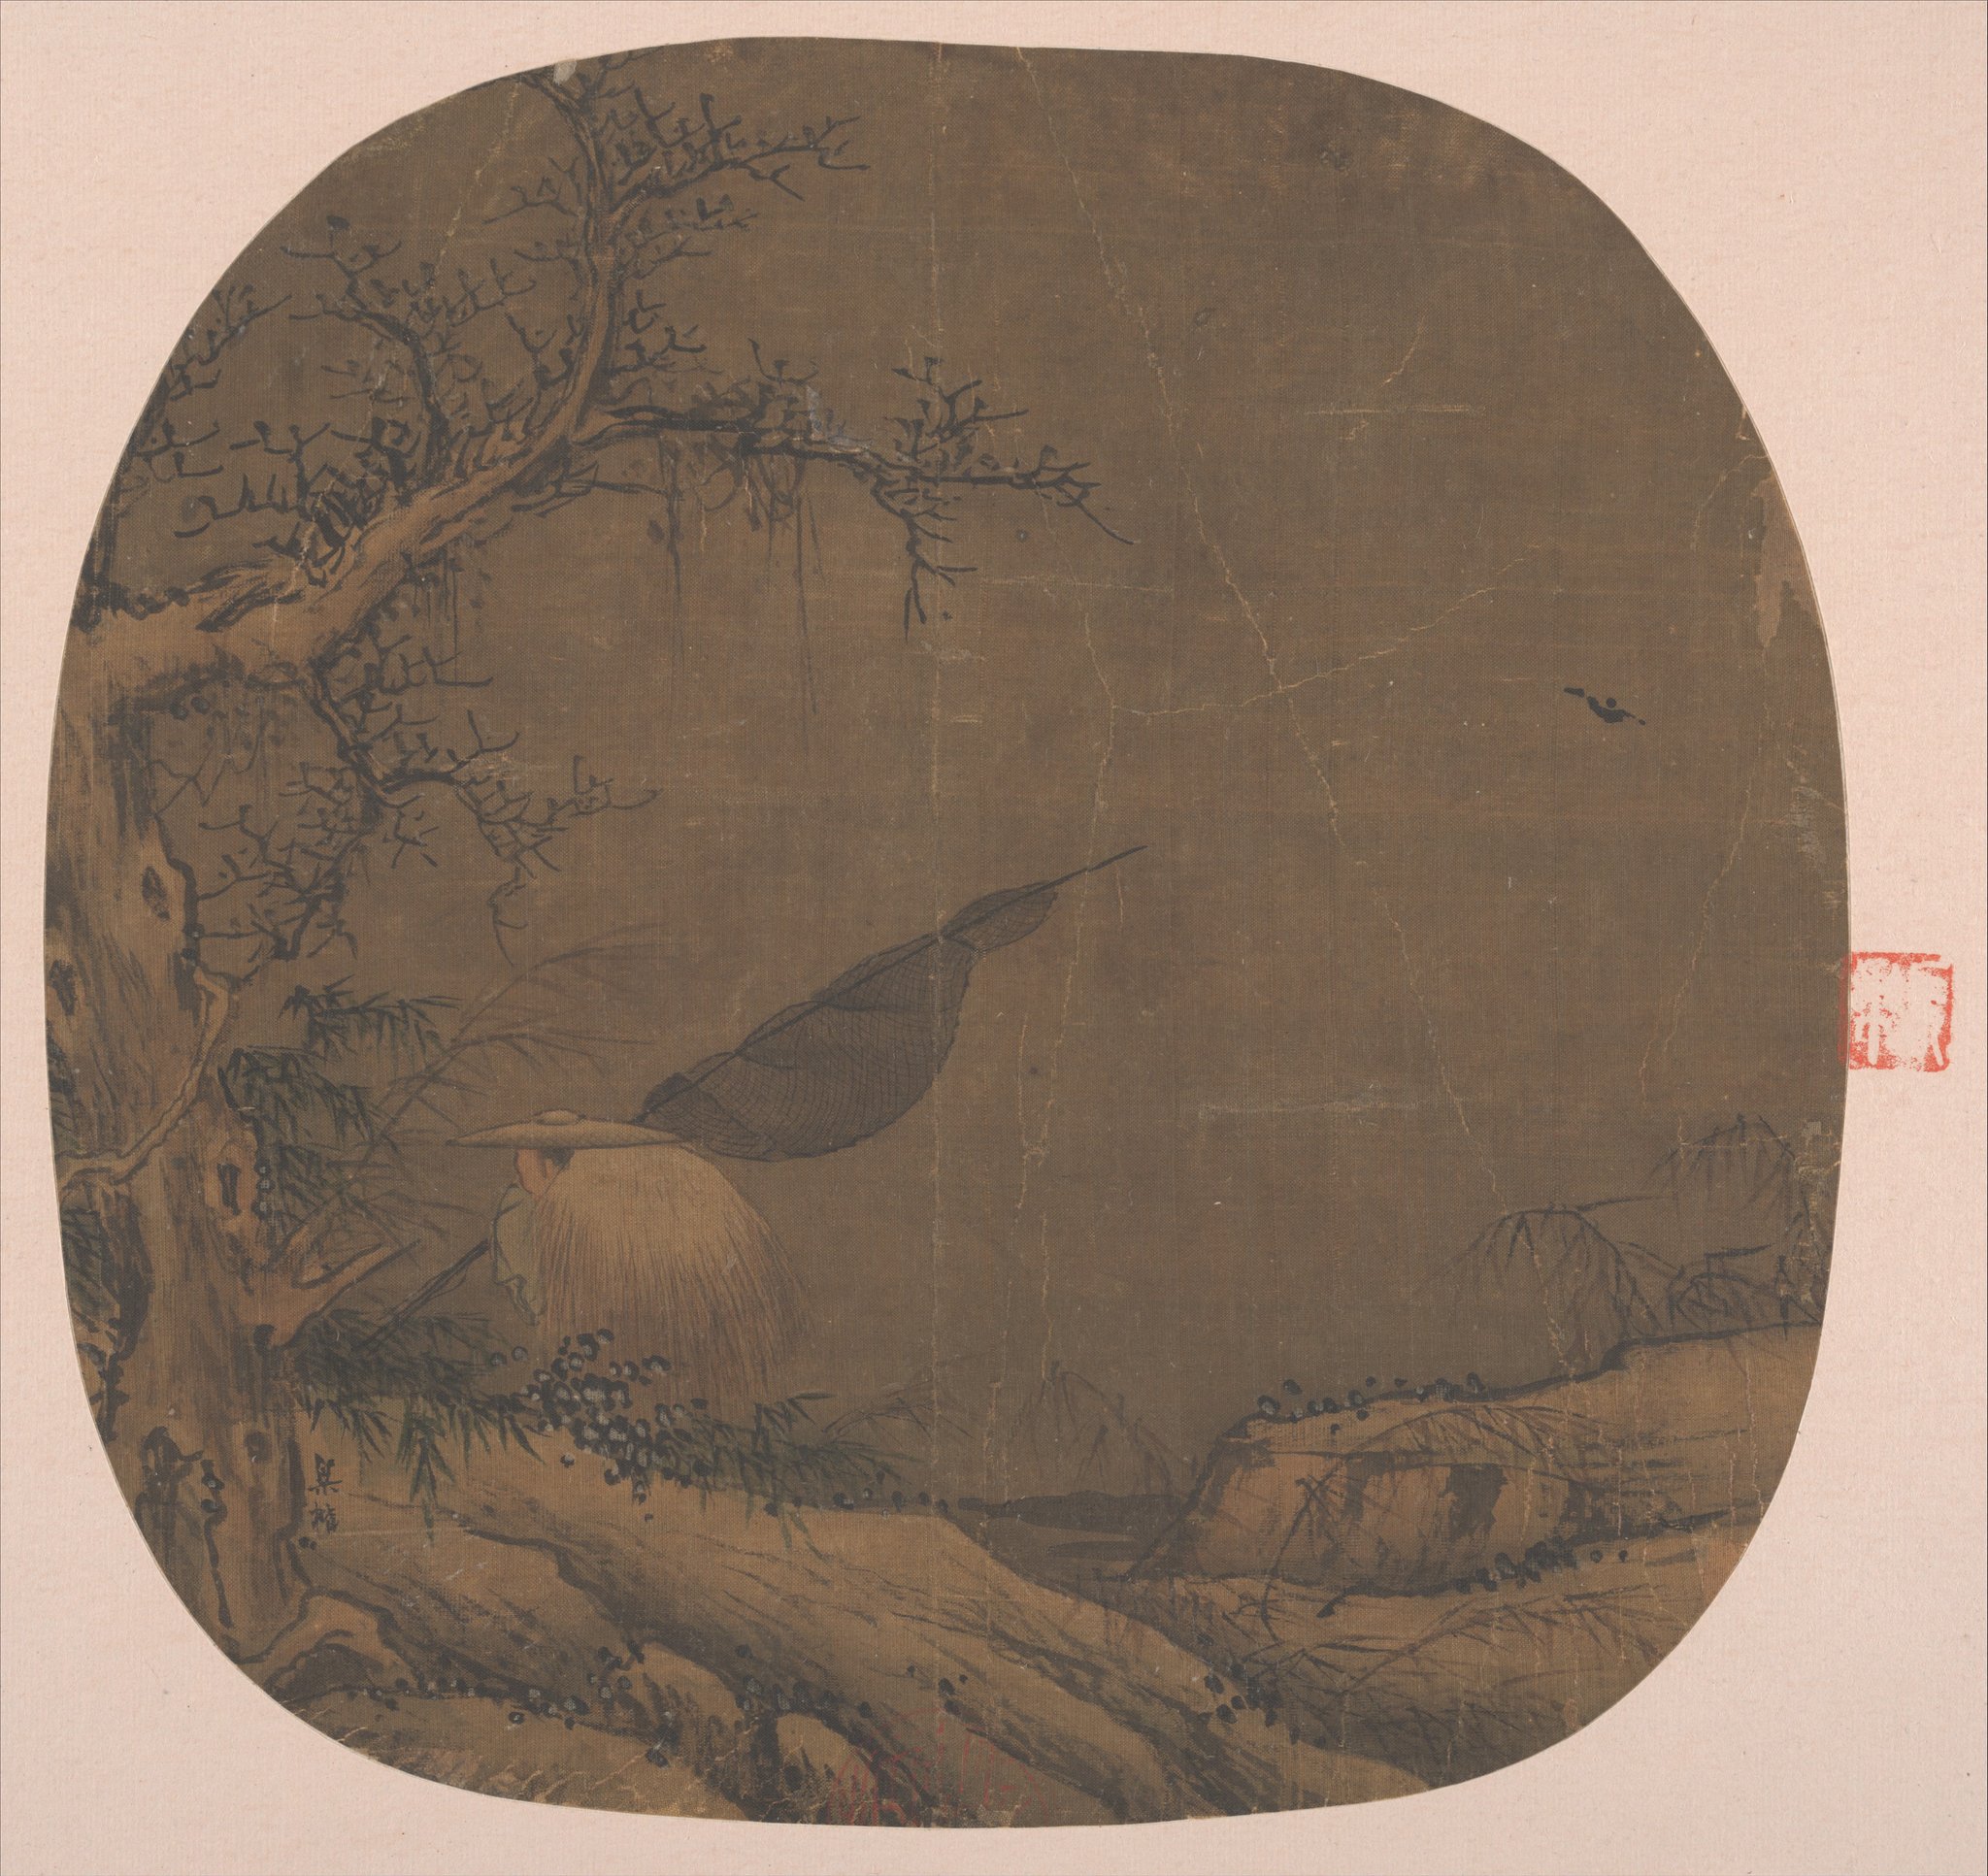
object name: fan mounted a an album leaf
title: Fisherman Returning Home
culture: chinese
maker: unidentified artist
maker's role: artist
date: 1368-1911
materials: ink, silk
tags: men,landscapes